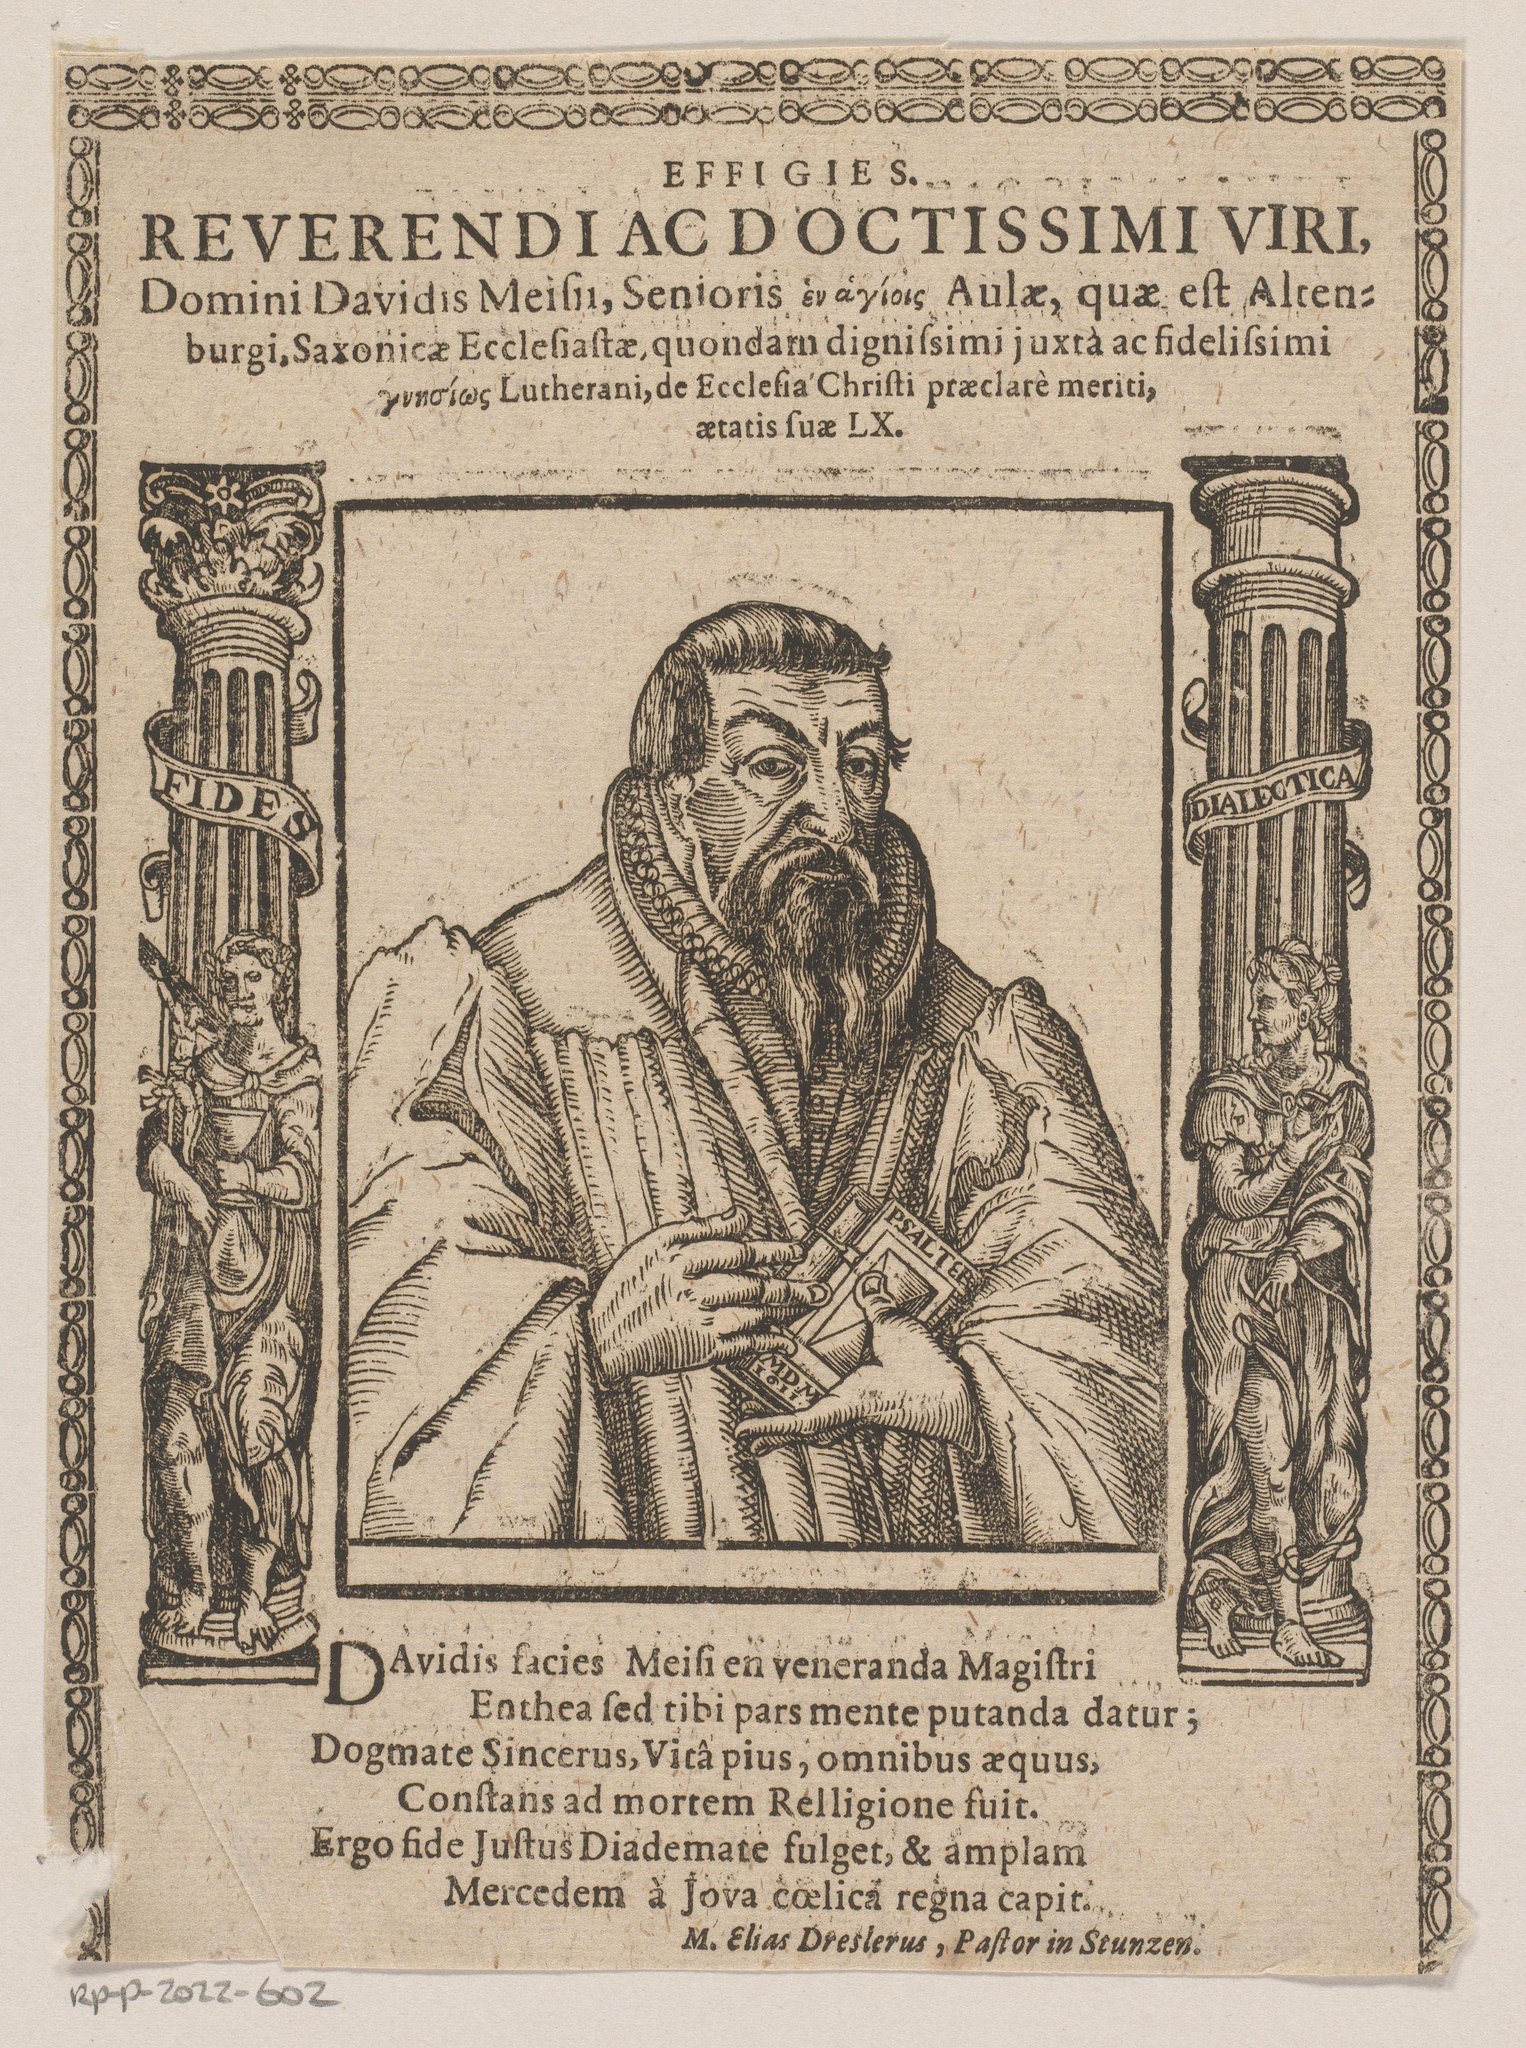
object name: print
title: Portret van David Meis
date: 1550-1700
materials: paper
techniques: letterpress printing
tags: historical persons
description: Met zesregelig onderschrift in het Latijn.